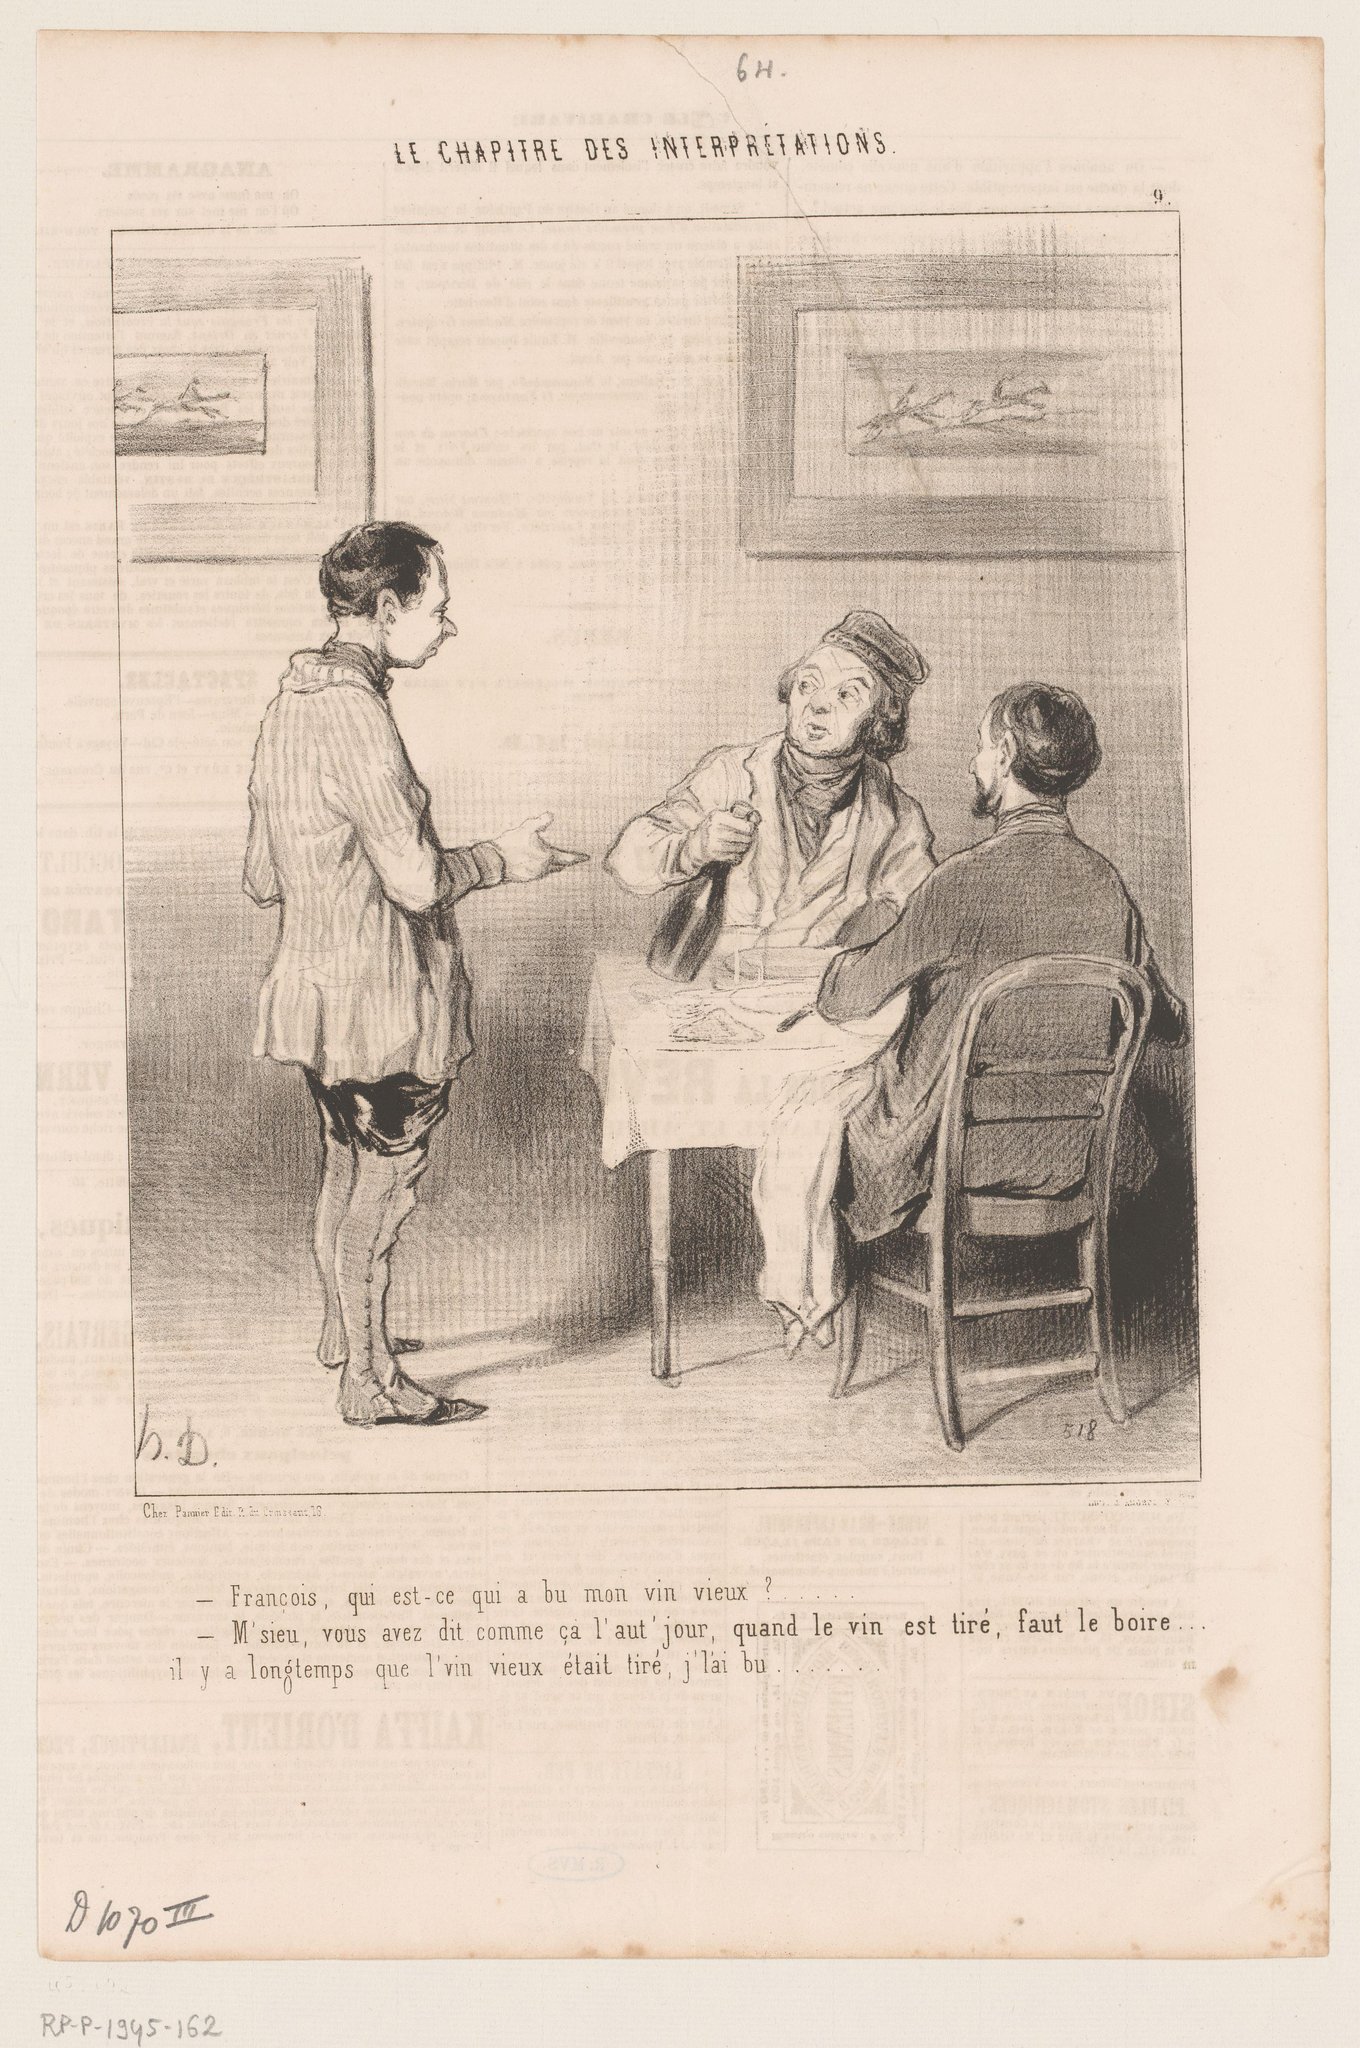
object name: cartoon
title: Communicatie en interpretatie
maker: honoré daumier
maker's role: draughtsman, painter, print maker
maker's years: 1808-1879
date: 1843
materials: paper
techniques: lithograph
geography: paris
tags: relation between master and servant, caricatures (human types), misunderstanding, bottle of wine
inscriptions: collector's mark: Lugt 2228a, number: ‘64’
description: De meester aan tafel met de wijnfles vraagt wie zijn oude wijn gedronken heeft. De staande knecht, François, biecht op dat hij dat heeft gedaan. Hij heeft een opmerking verkeerd begrepen.